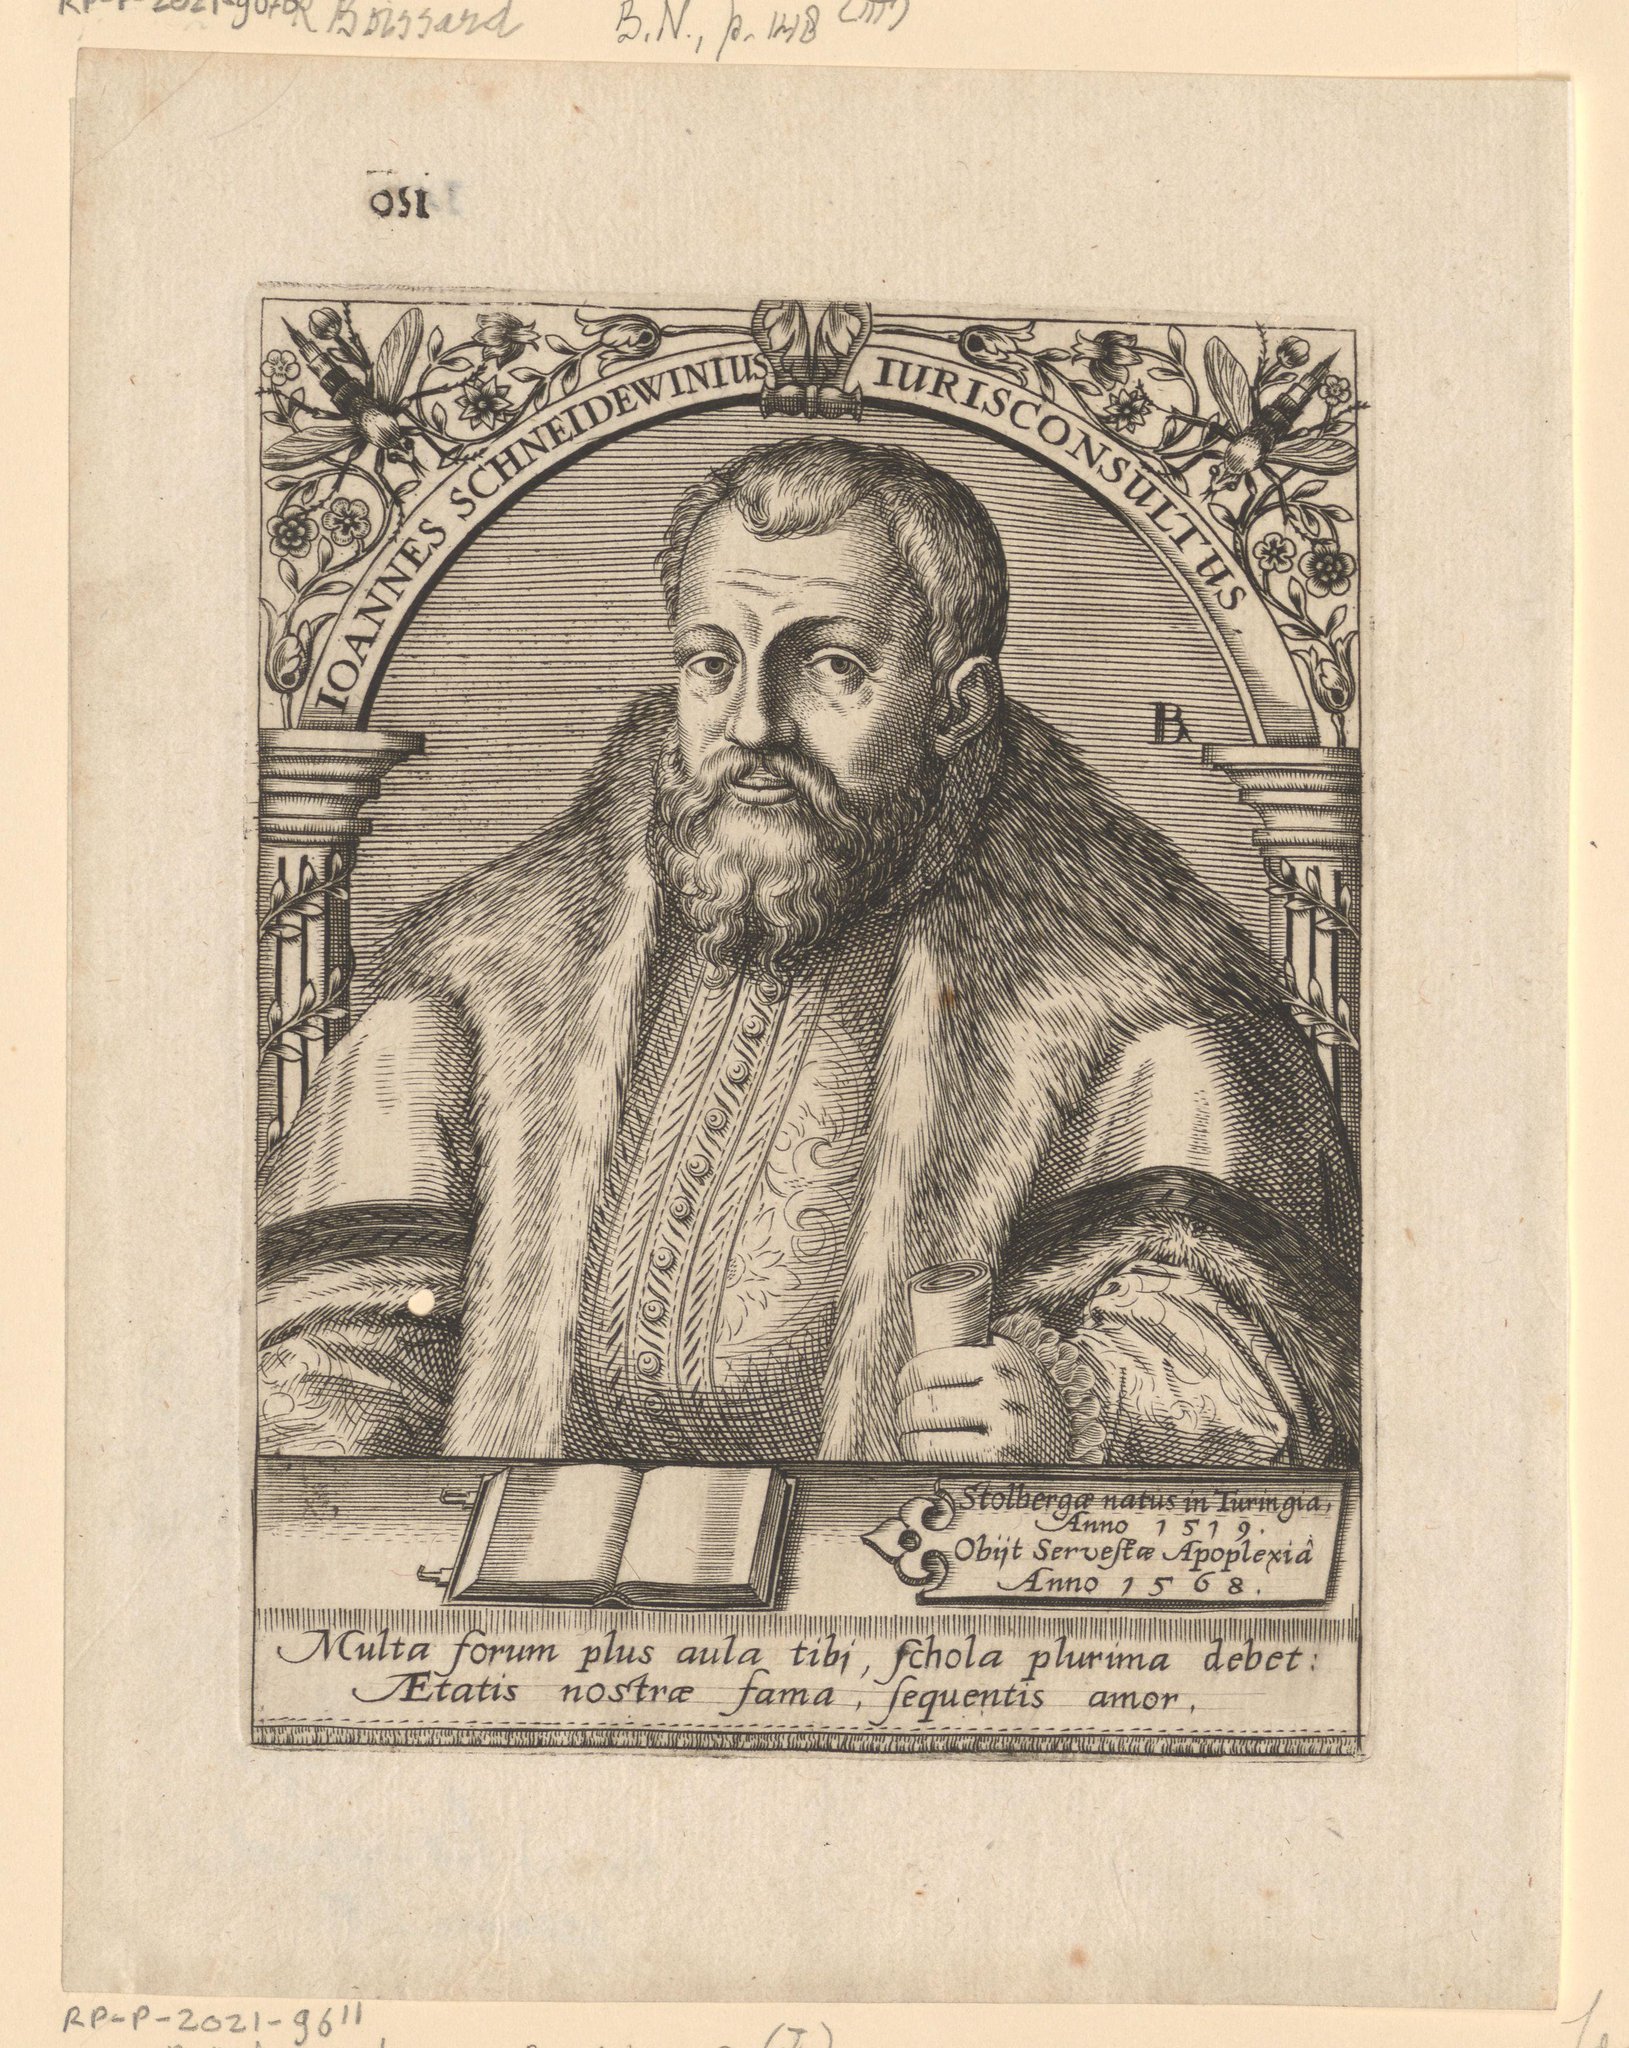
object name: print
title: Portret van Johann Schneidewein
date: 1598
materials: paper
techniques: engraving, letterpress printing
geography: frankfurt am main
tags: historical persons, book - mm - book open, law and jurisprudence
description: Prent uit: Boissard, Jean Jacques. Icones quinquaginta virorum illustrium doctrina & eruditione praestantium ad vivum effictae. Frankfurt am Main: Theodoor de Bry, 1598, dl. 2, p. 150